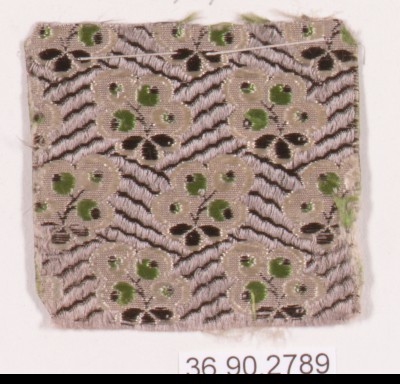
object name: piece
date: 1801-1900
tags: leaves